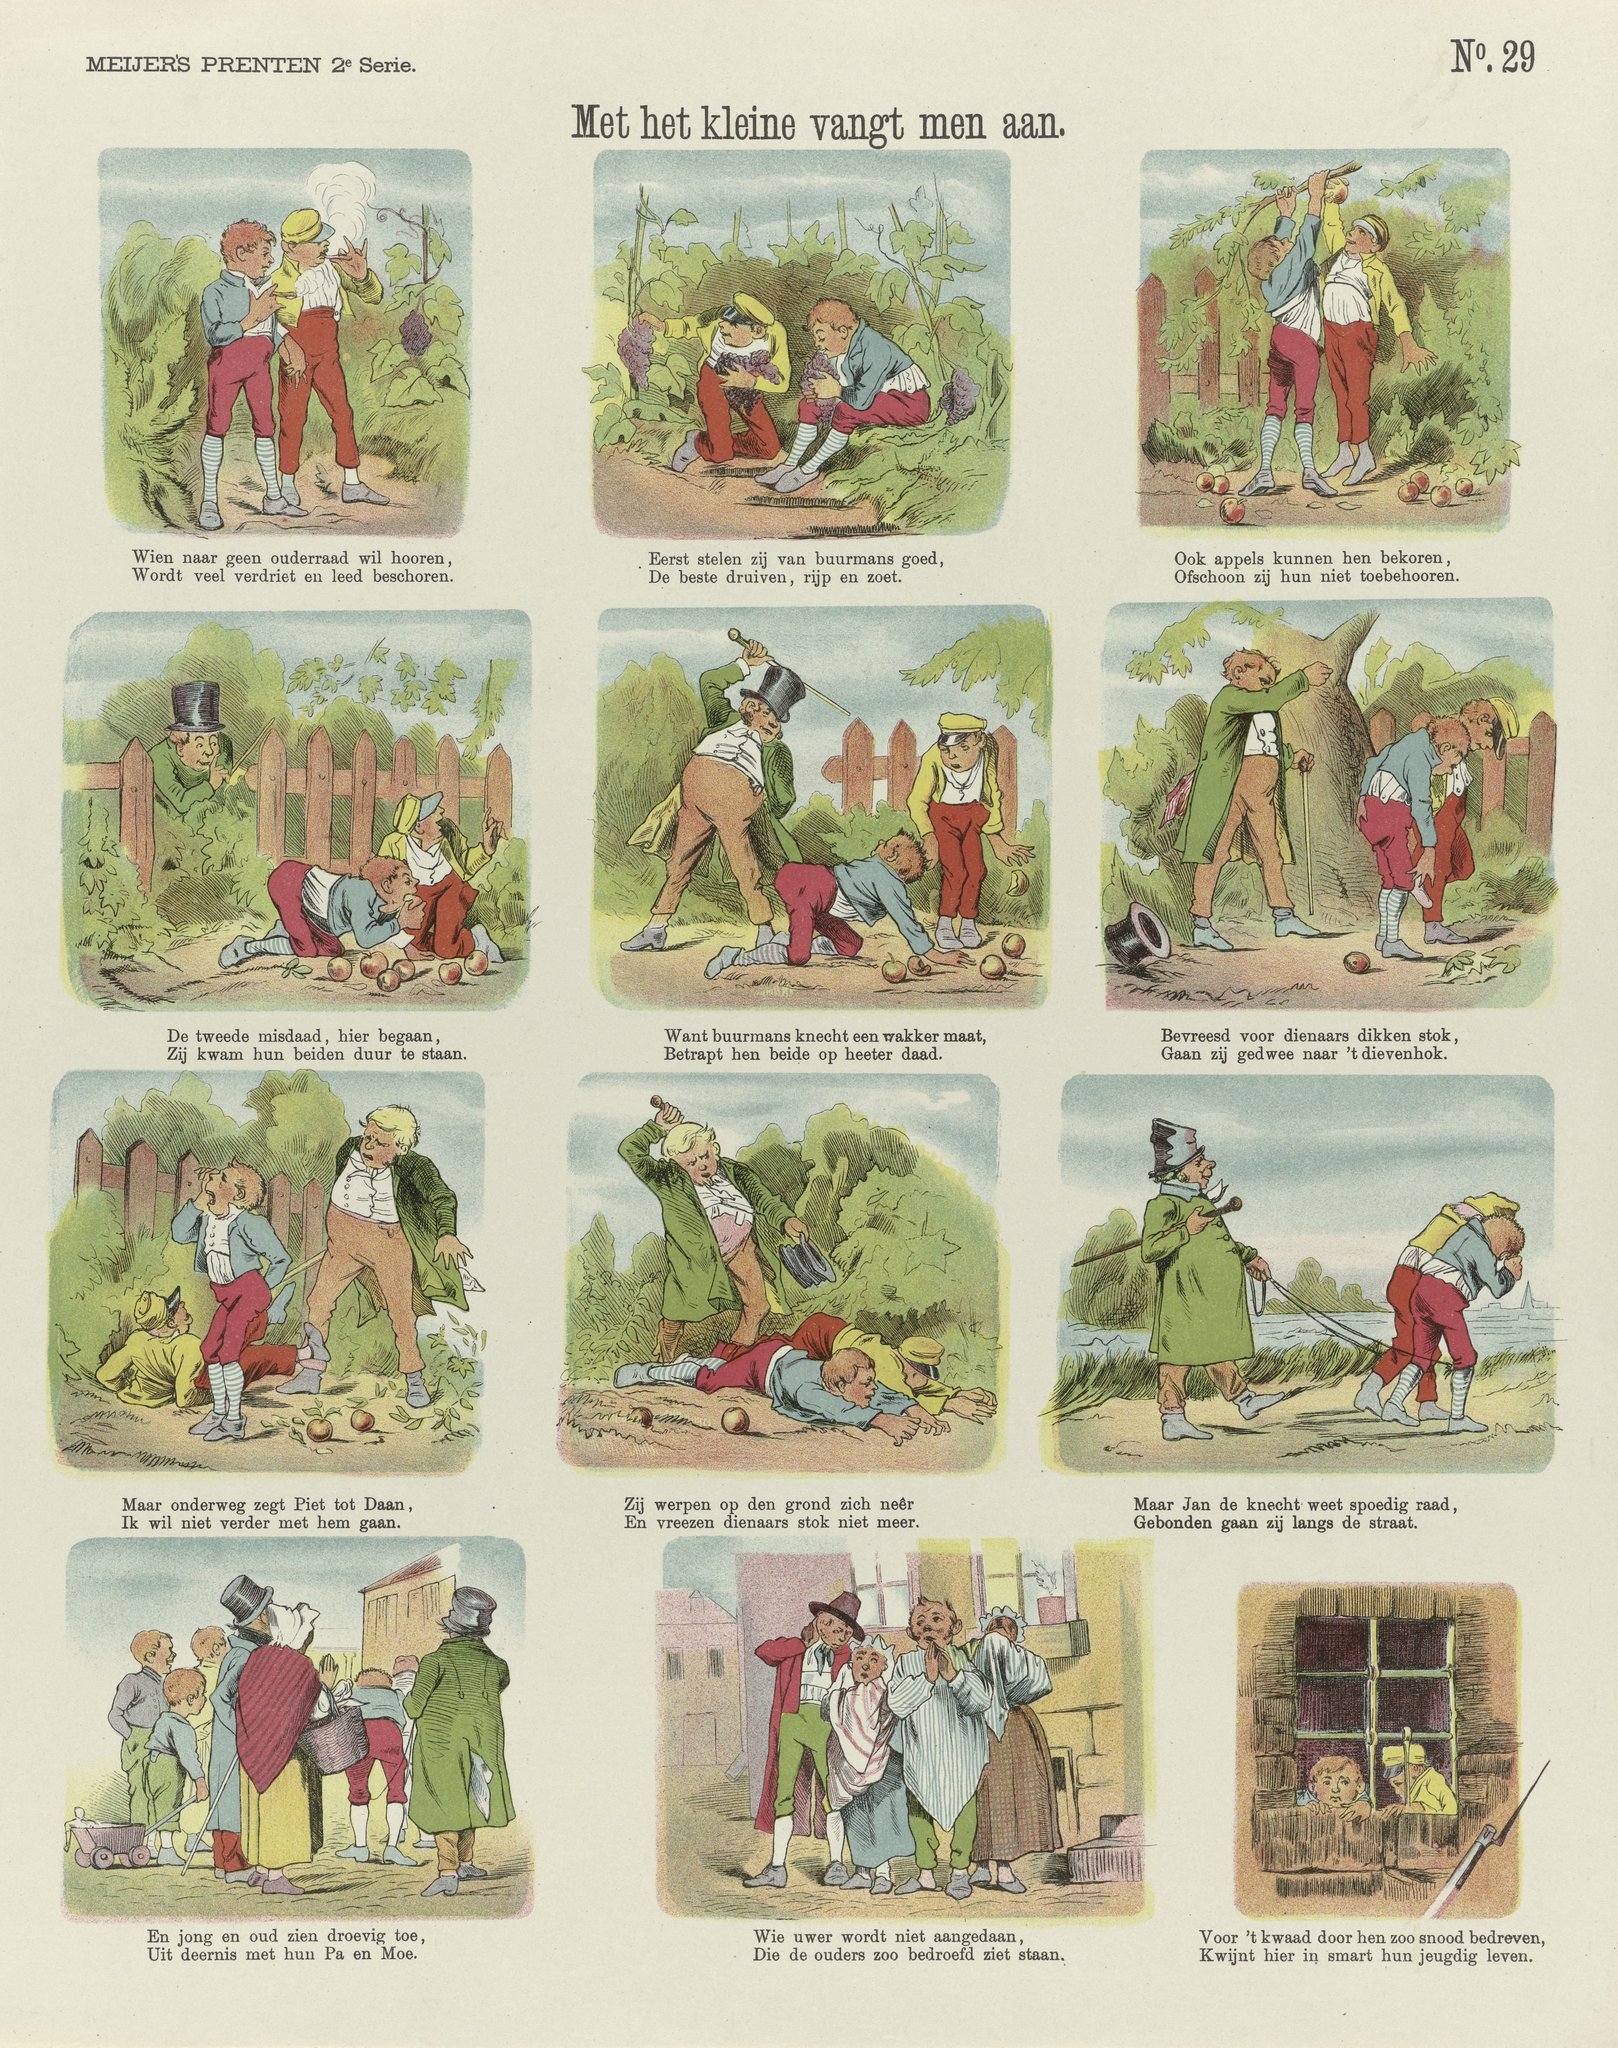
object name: popular print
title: Meijer's prenten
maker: Anonymous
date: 1874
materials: paper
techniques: lithograph, letterpress printing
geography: amsterdam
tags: correction of naughty children, theft, imprisonment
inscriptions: collector's mark: Lugt 2760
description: Blad met 12 voorstellingen over twee jonge deugnieten die uiteindelijk in het gevang komen voor peren diefstal. Onder elke afbeelding een tweeregelig vers. Genummerd rechtsboven: No. 29.